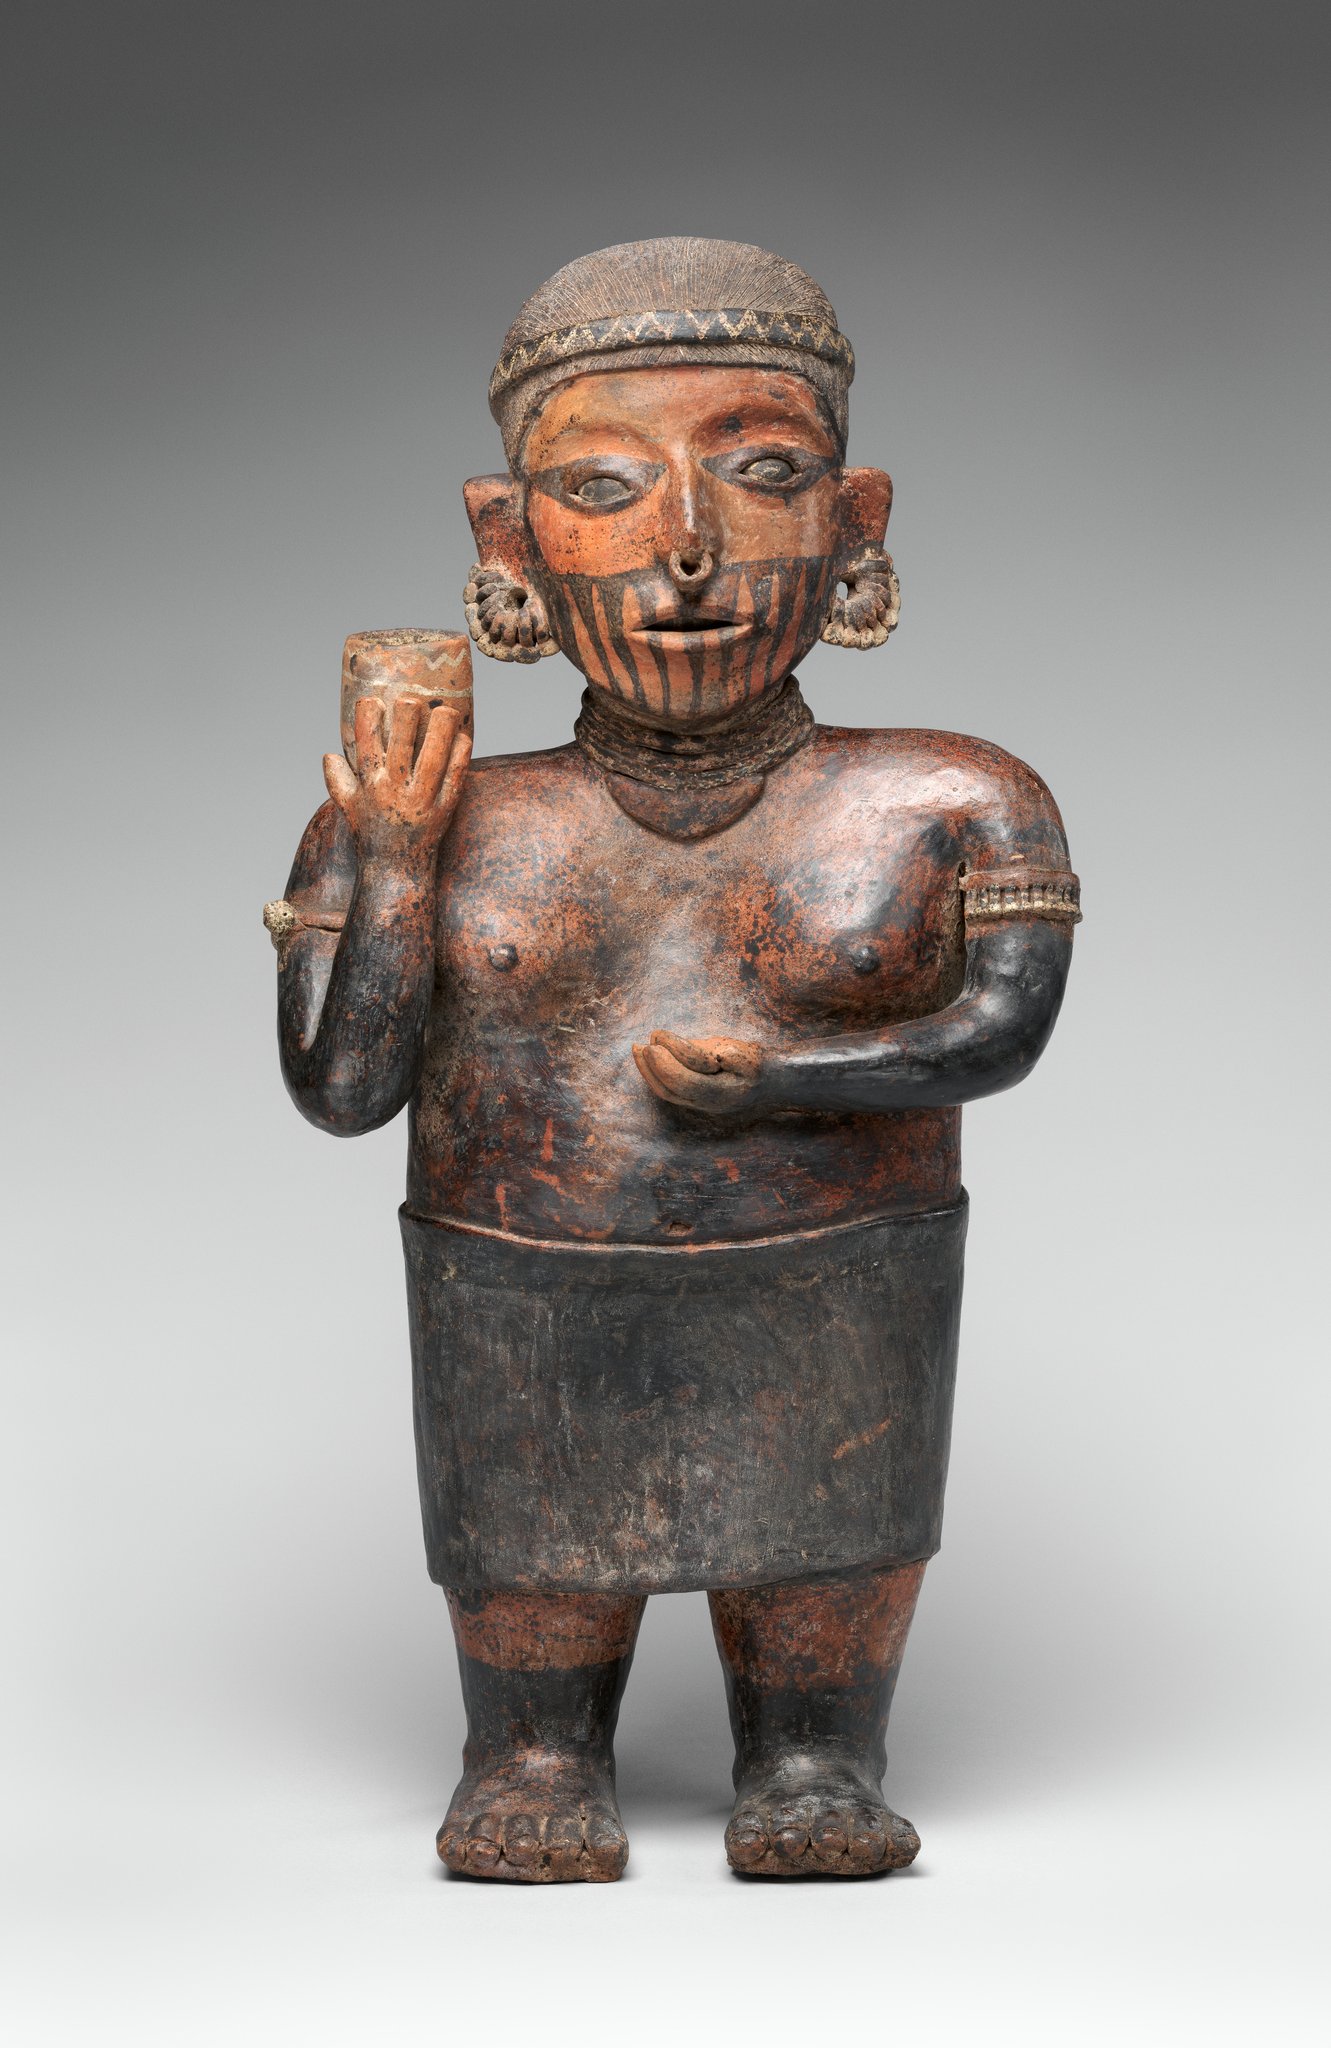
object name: female figure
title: Standing female figure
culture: nayarit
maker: nayarit artist(s)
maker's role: artist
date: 100-400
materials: ceramic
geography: mexico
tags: women